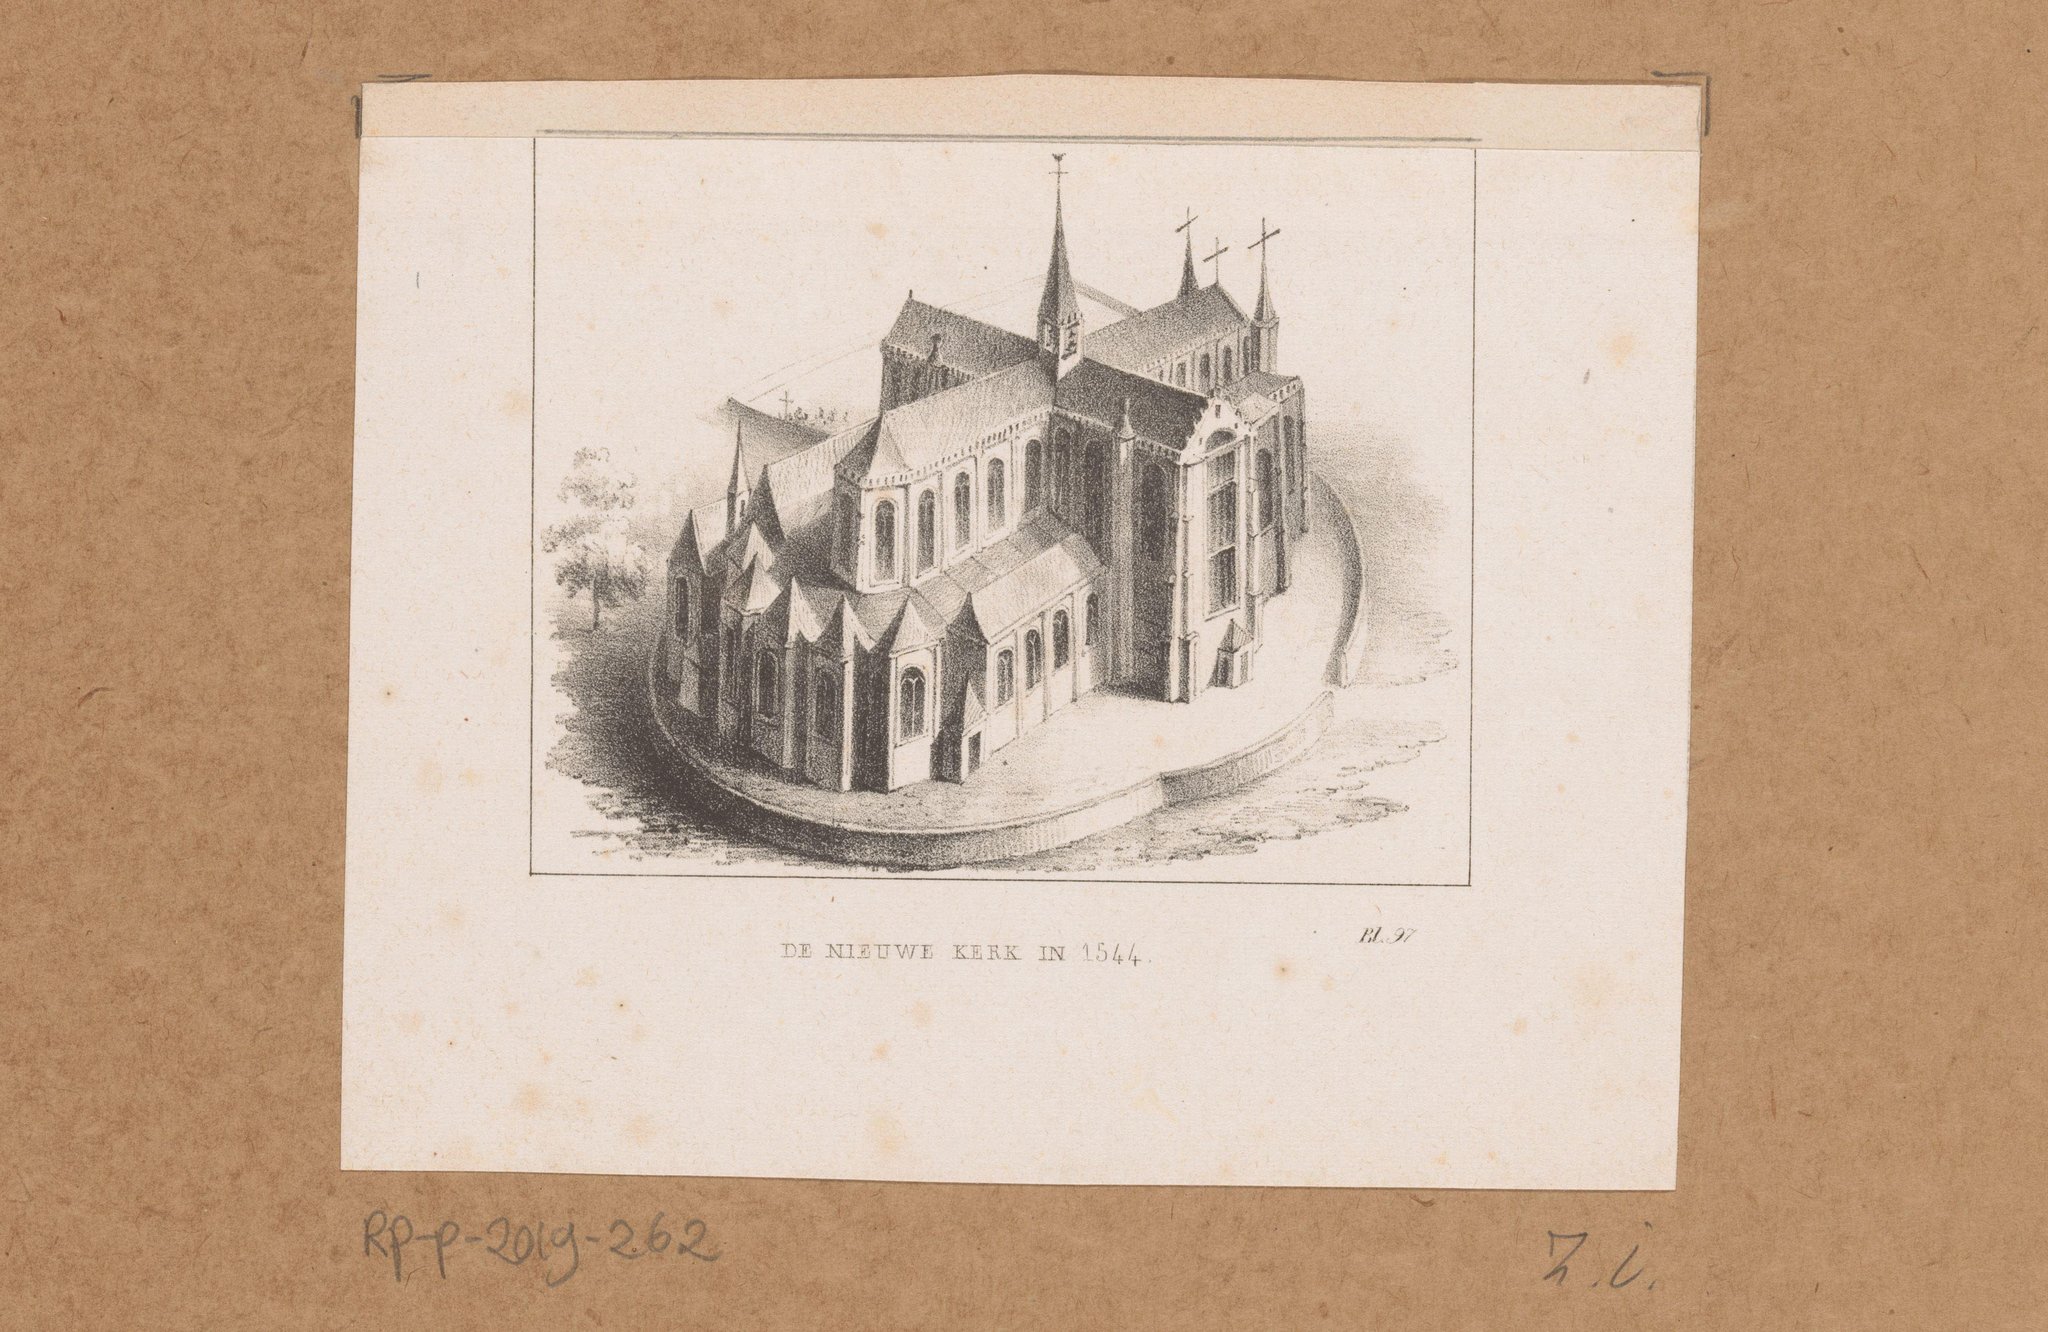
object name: book illustration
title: De Nieuwe Kerk in 1544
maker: johannes hilverdink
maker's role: draughtsman, painter, print maker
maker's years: 1813-1902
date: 1844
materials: paper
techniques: lithograph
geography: amsterdam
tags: church (exterior)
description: Prent uit: Vijver, C. van der. Geschiedkundige beschrijving der stad Amsterdam. Amsterdam: Diederichs, Gebroeders, 1844, dl. 1, p. 97.